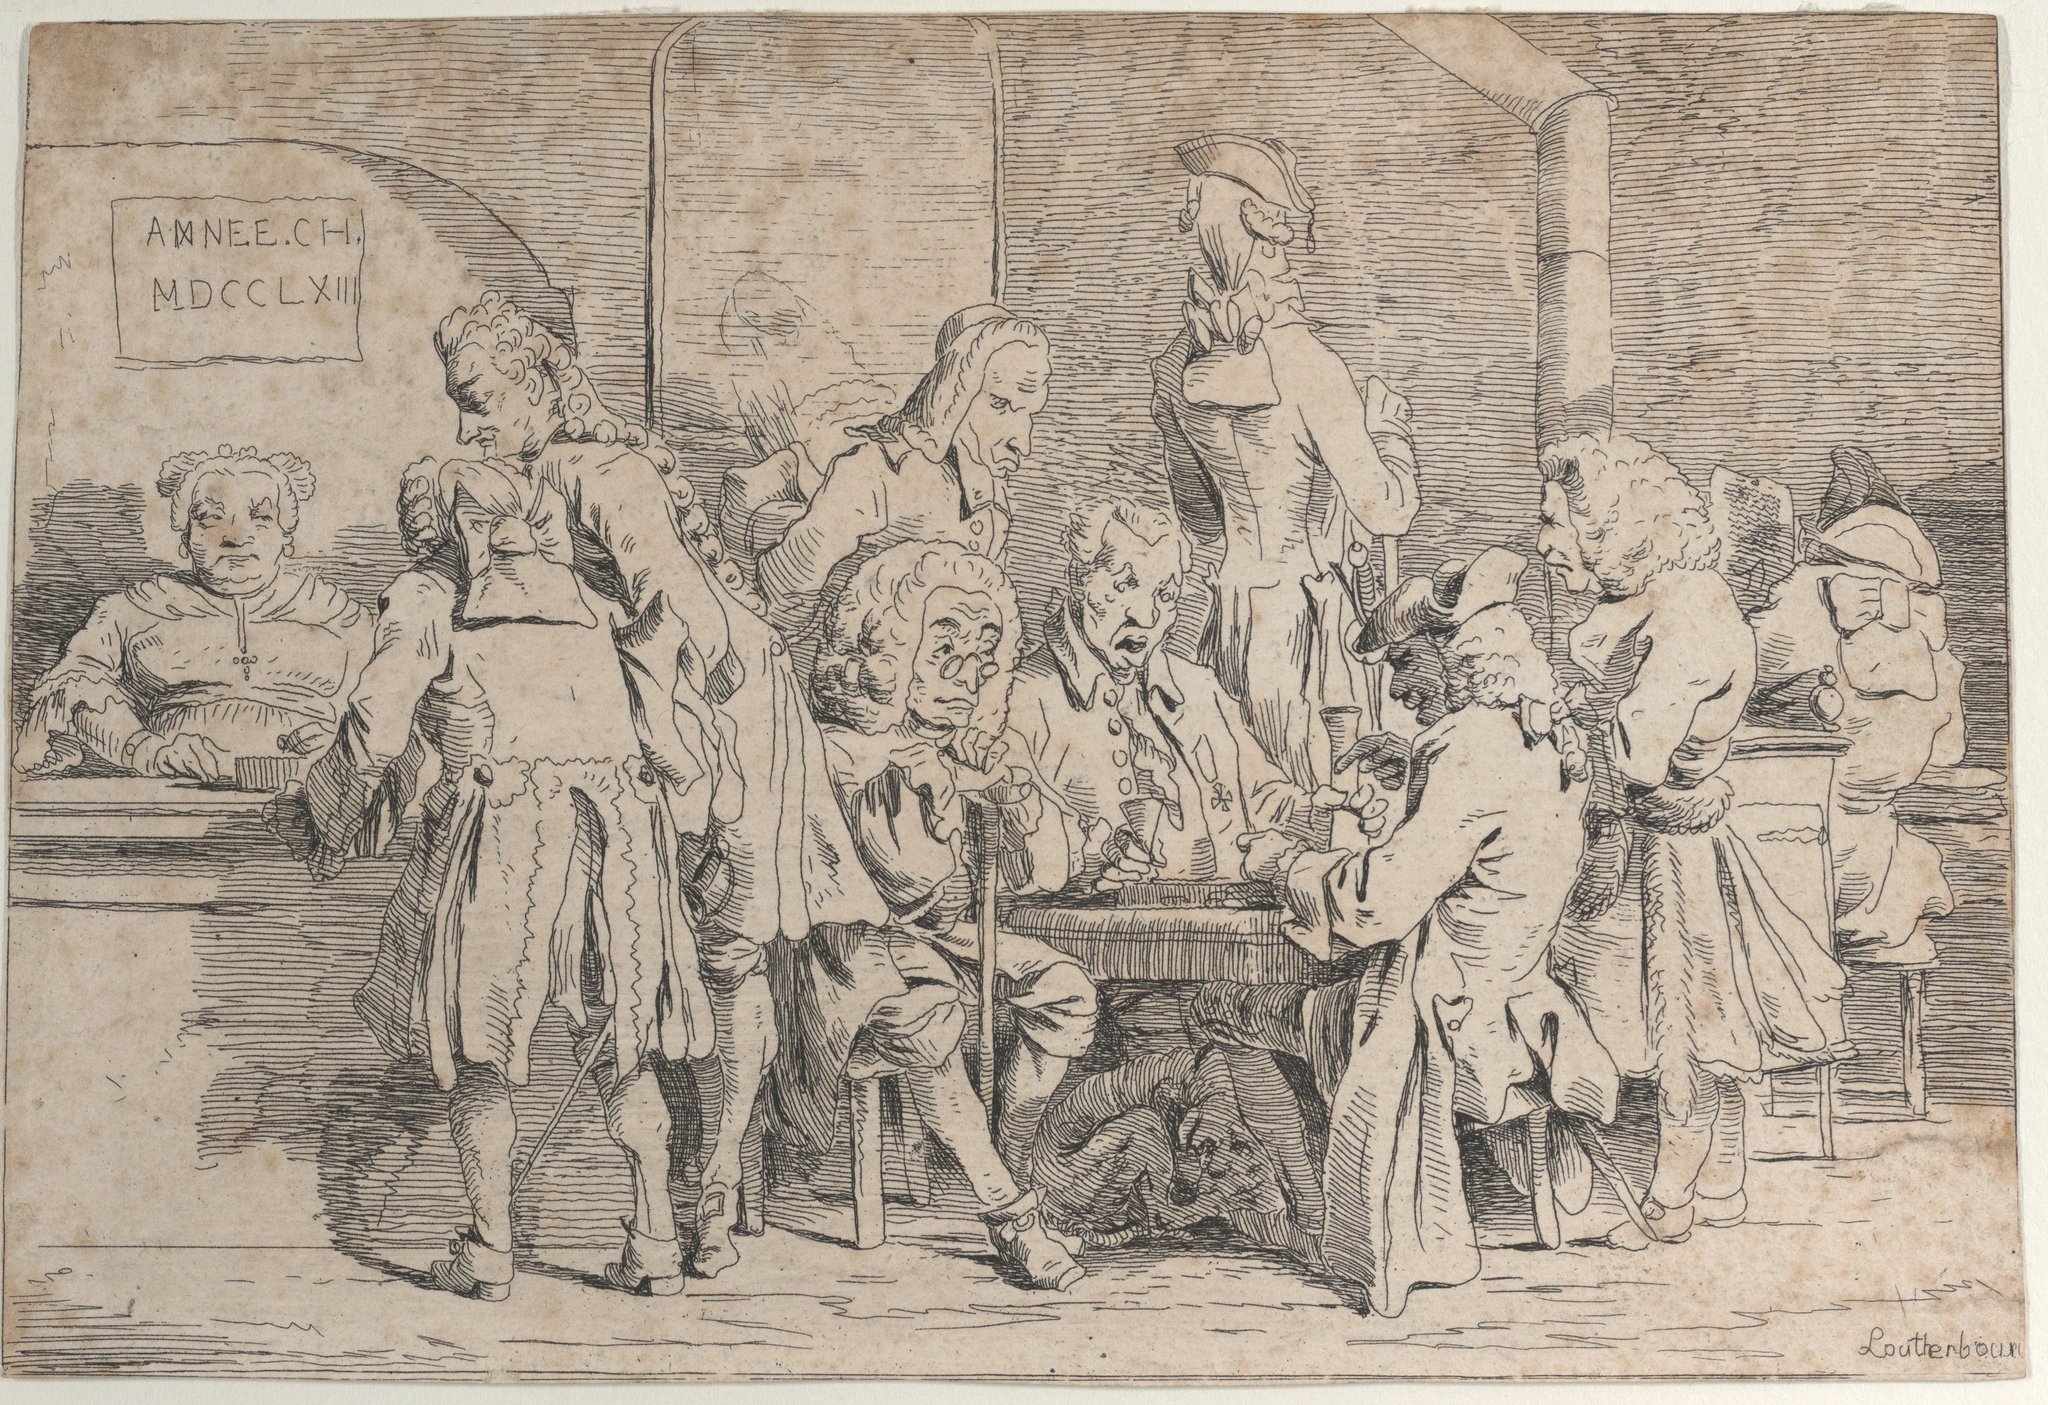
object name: print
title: Playing Tric Trac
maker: philippe jacques de loutherbourg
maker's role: artist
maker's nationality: french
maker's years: 1740-1812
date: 1763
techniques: etching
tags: men,women,dogs,games,caricature